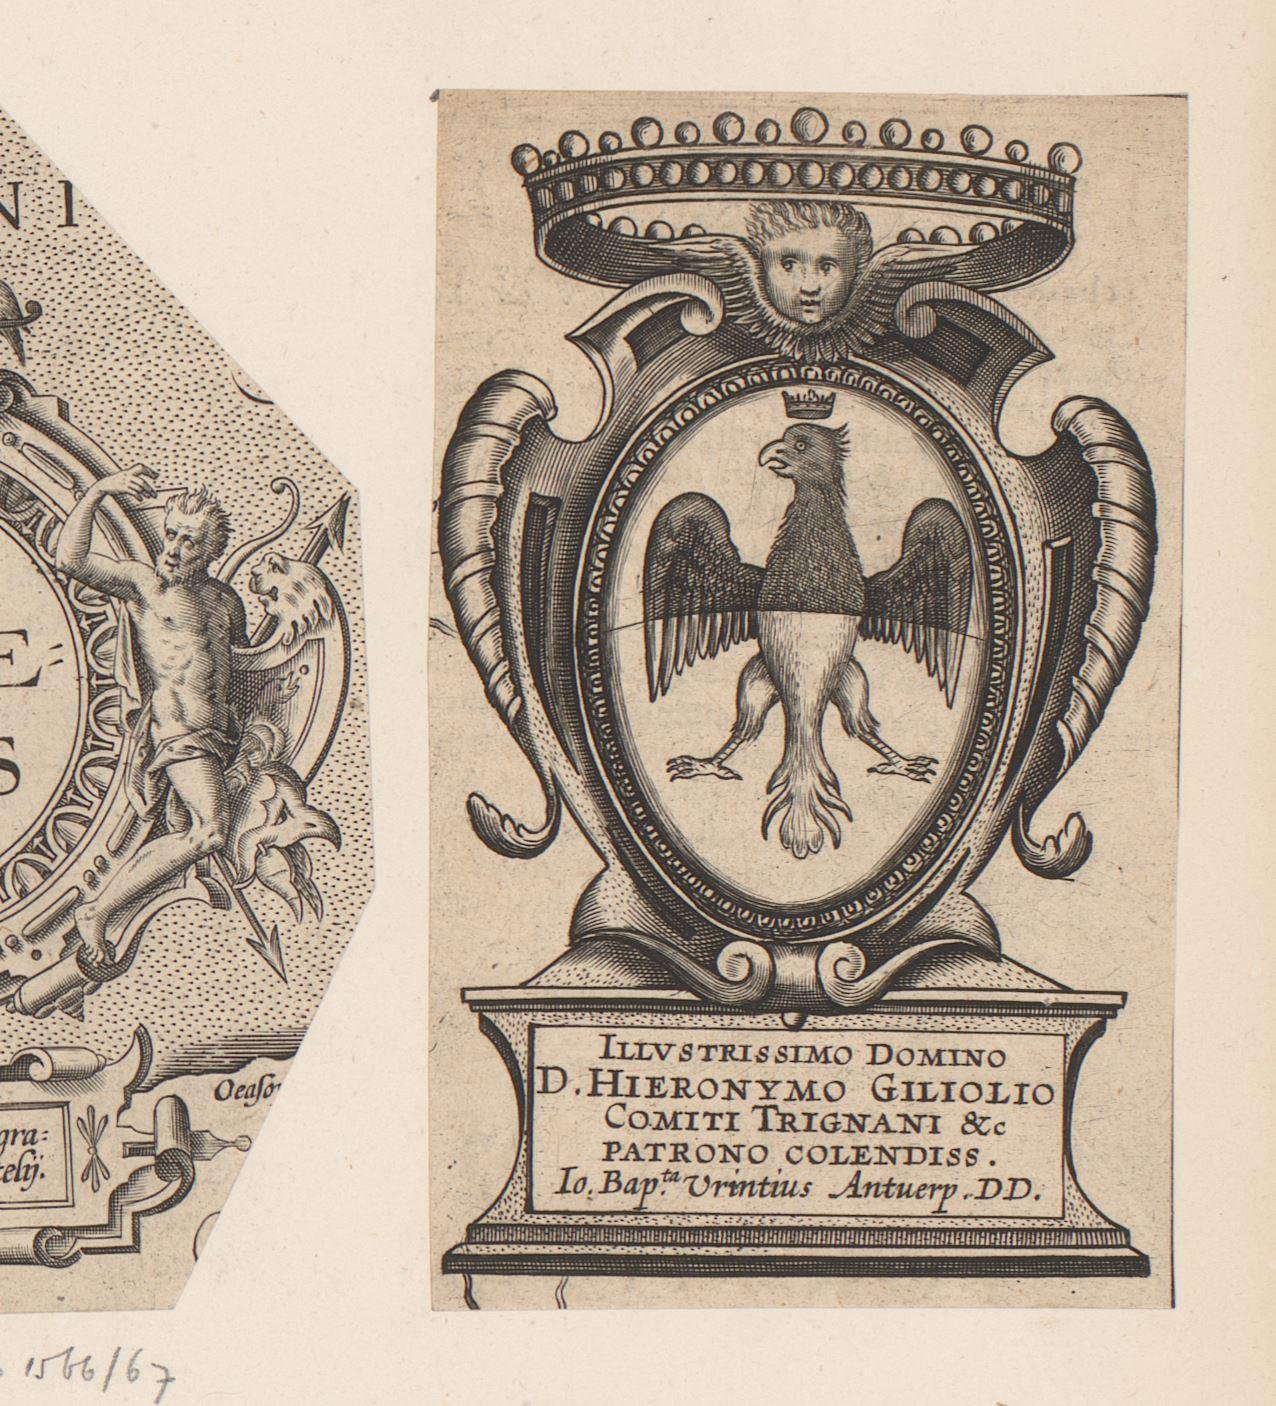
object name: ornament print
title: Ducatus Ferrariensis, Finitimarumque Partium Descriptio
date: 1608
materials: paper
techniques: engraving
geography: antwerp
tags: predatory birds: eagle, ornament ~ cartouche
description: Cartouche met cherubijn en kroon. In de cartouche een gekroonde adelaar. Daaronder een vijfregelige dedicatietekst. De cartouche is een fragment van een kaart van het hertogdom Ferrara. De prent maakt deel uit van een album.